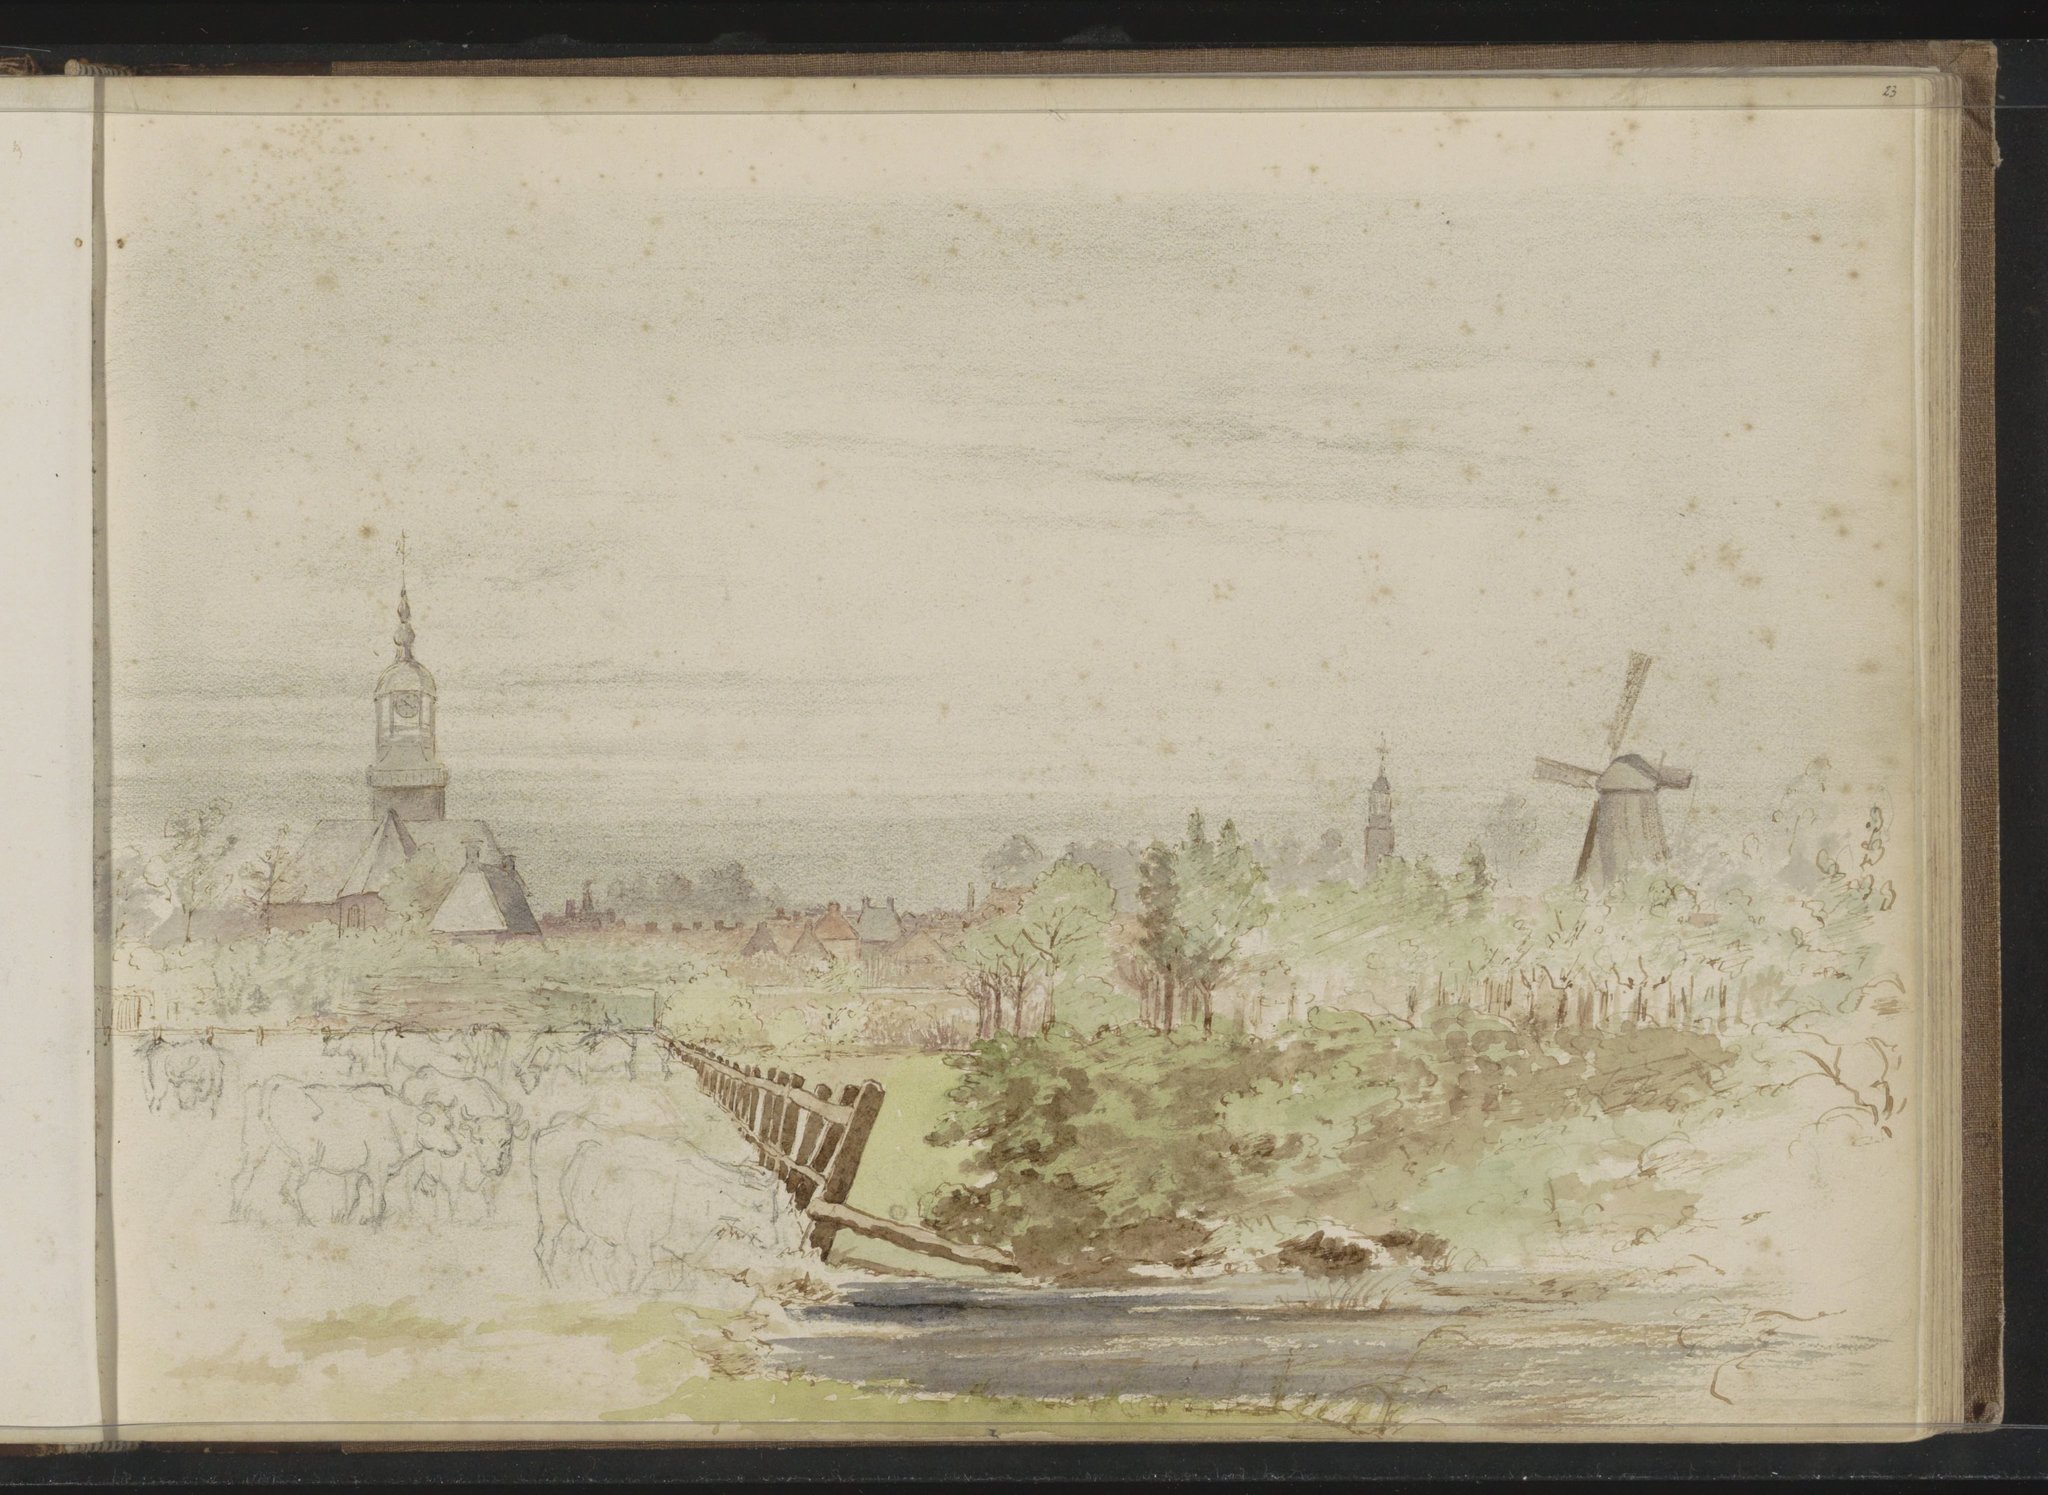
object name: sketchbook leaf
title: Gezicht op Almelo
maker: hendrik valkenburg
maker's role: draughtsman, painter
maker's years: 1826-1896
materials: ink, paper, pencil, watercolor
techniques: brush, pen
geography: almelo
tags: city-view, and landscape with man-made constructions, cattle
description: Op de voorgrond grazend vee in een weiland grenzend aan het water. Blad 23 recto uit een schetsboek met 77 bladen.